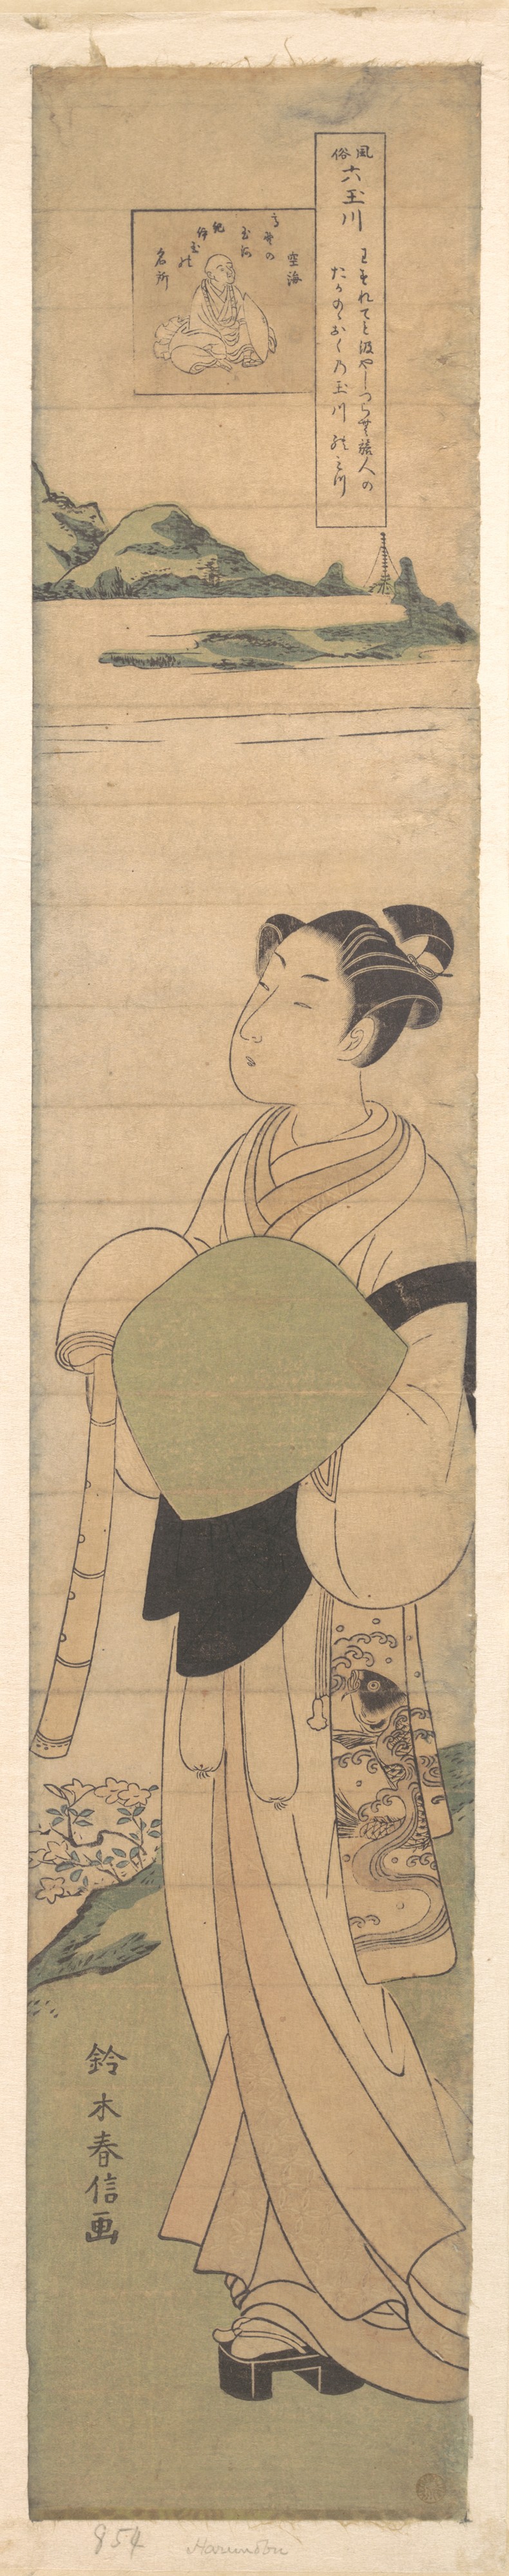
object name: print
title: A Young Komuso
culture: japanese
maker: suzuki harunobu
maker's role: artist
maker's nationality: japanese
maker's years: 1725-1770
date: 1768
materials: ink, paper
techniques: woodblock print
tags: women,monks